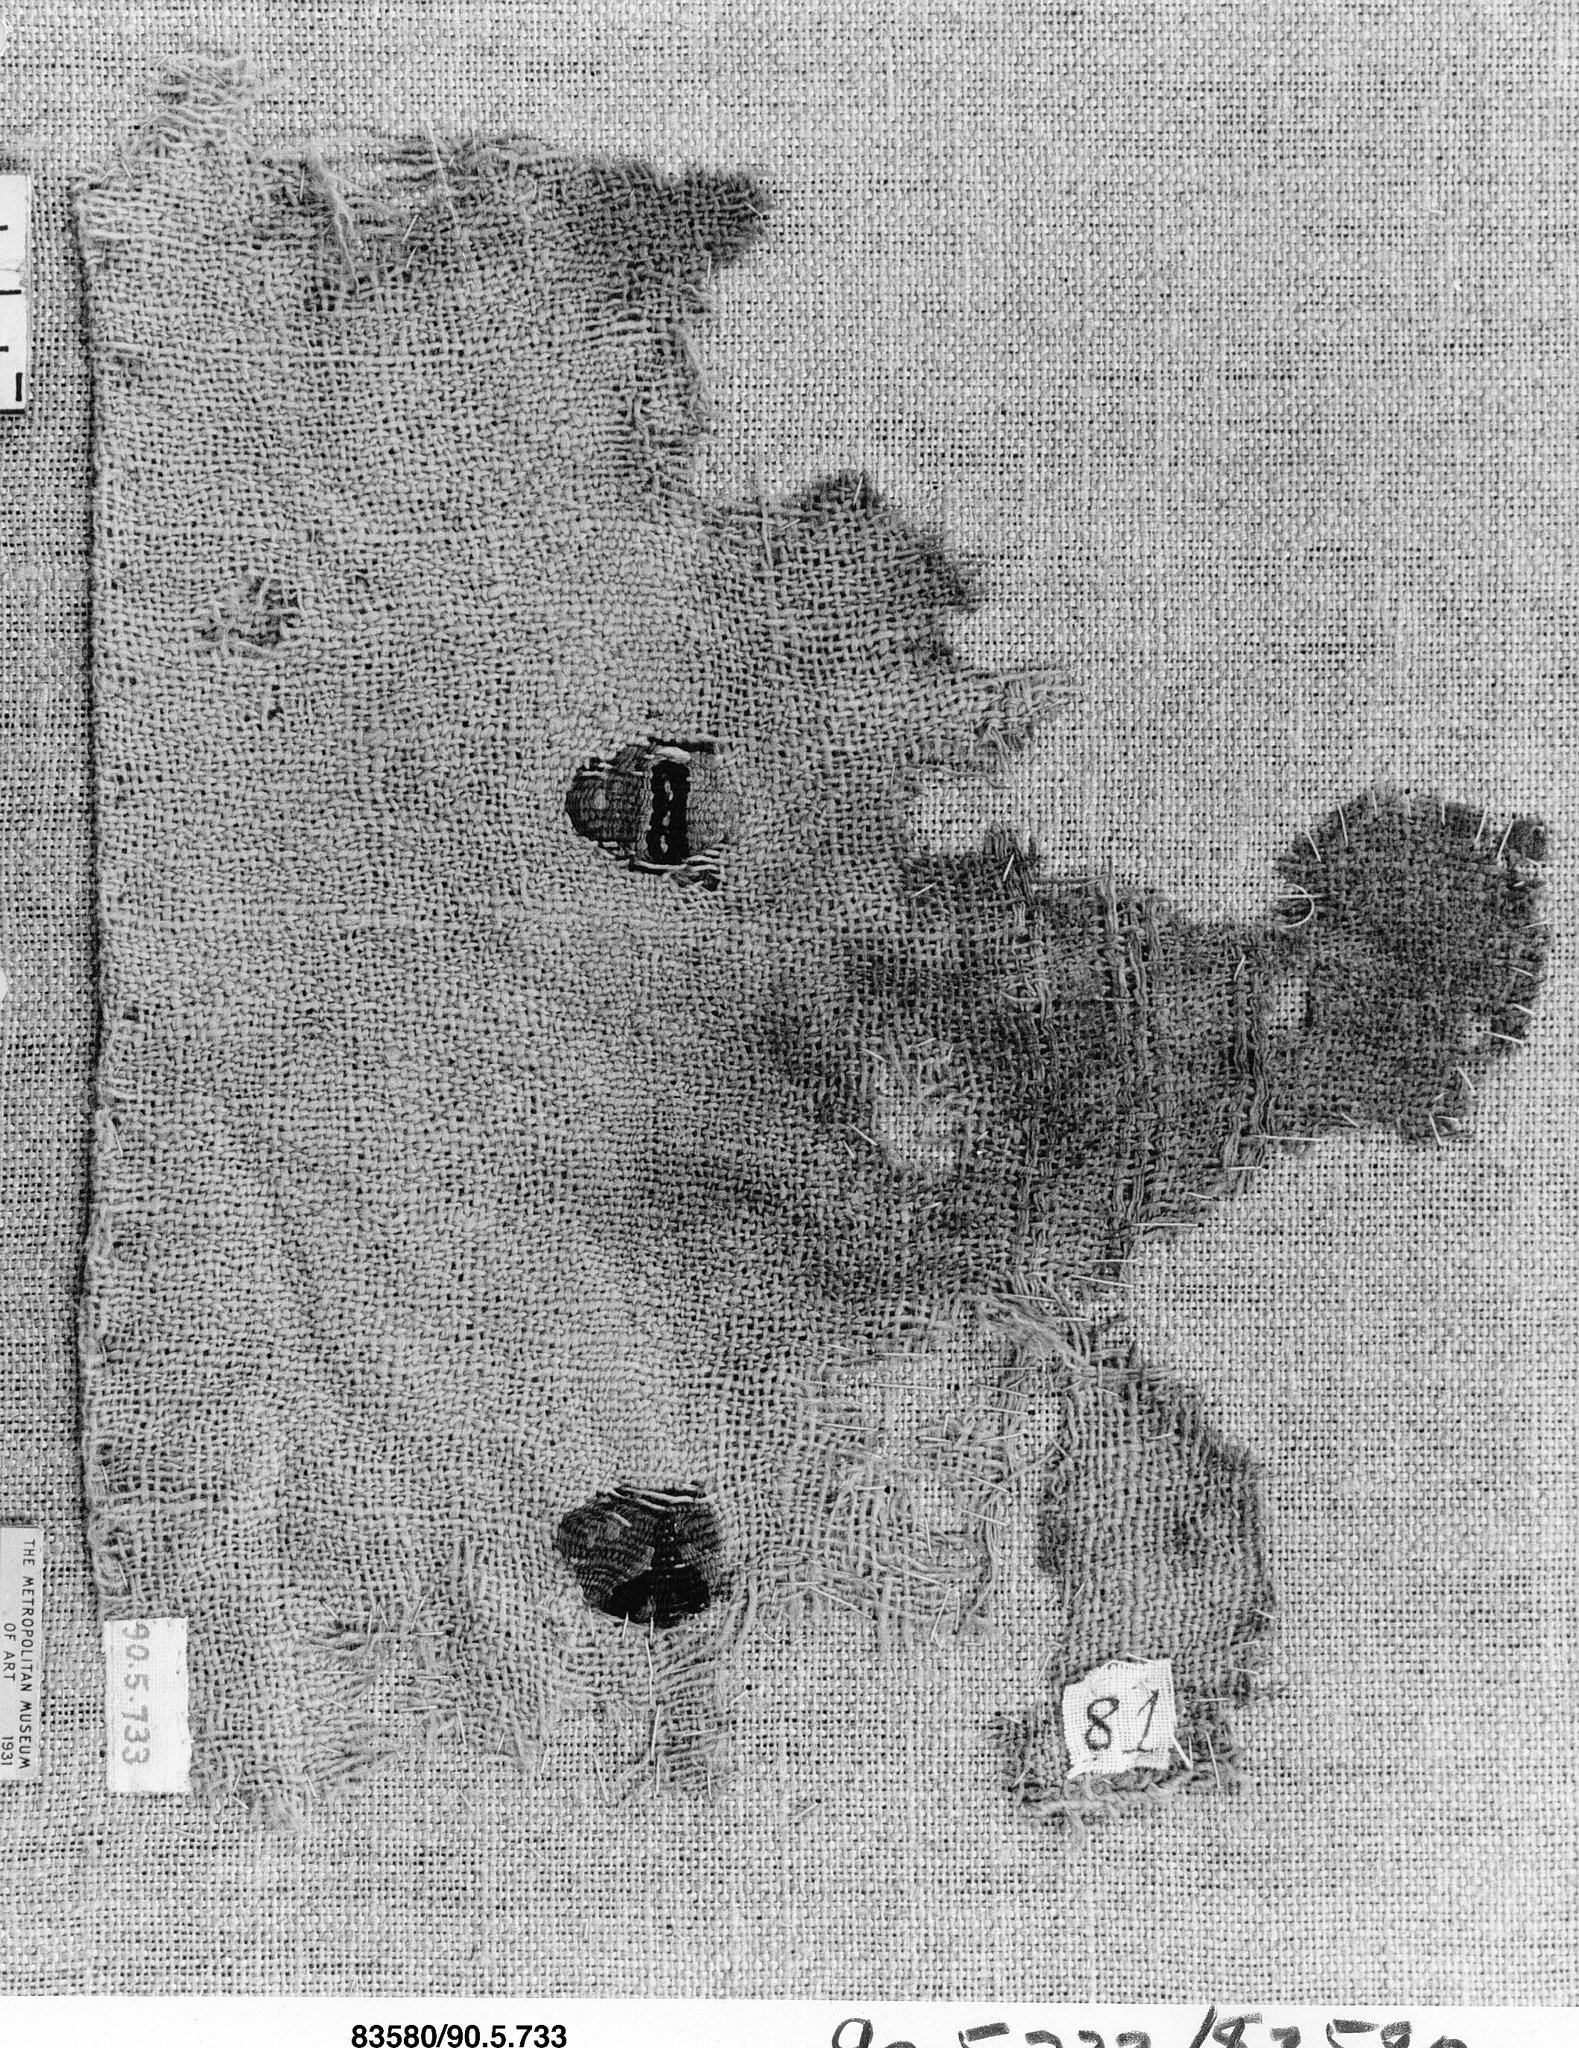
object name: textile fragment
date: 401-600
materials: linen, wool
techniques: weave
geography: egypt